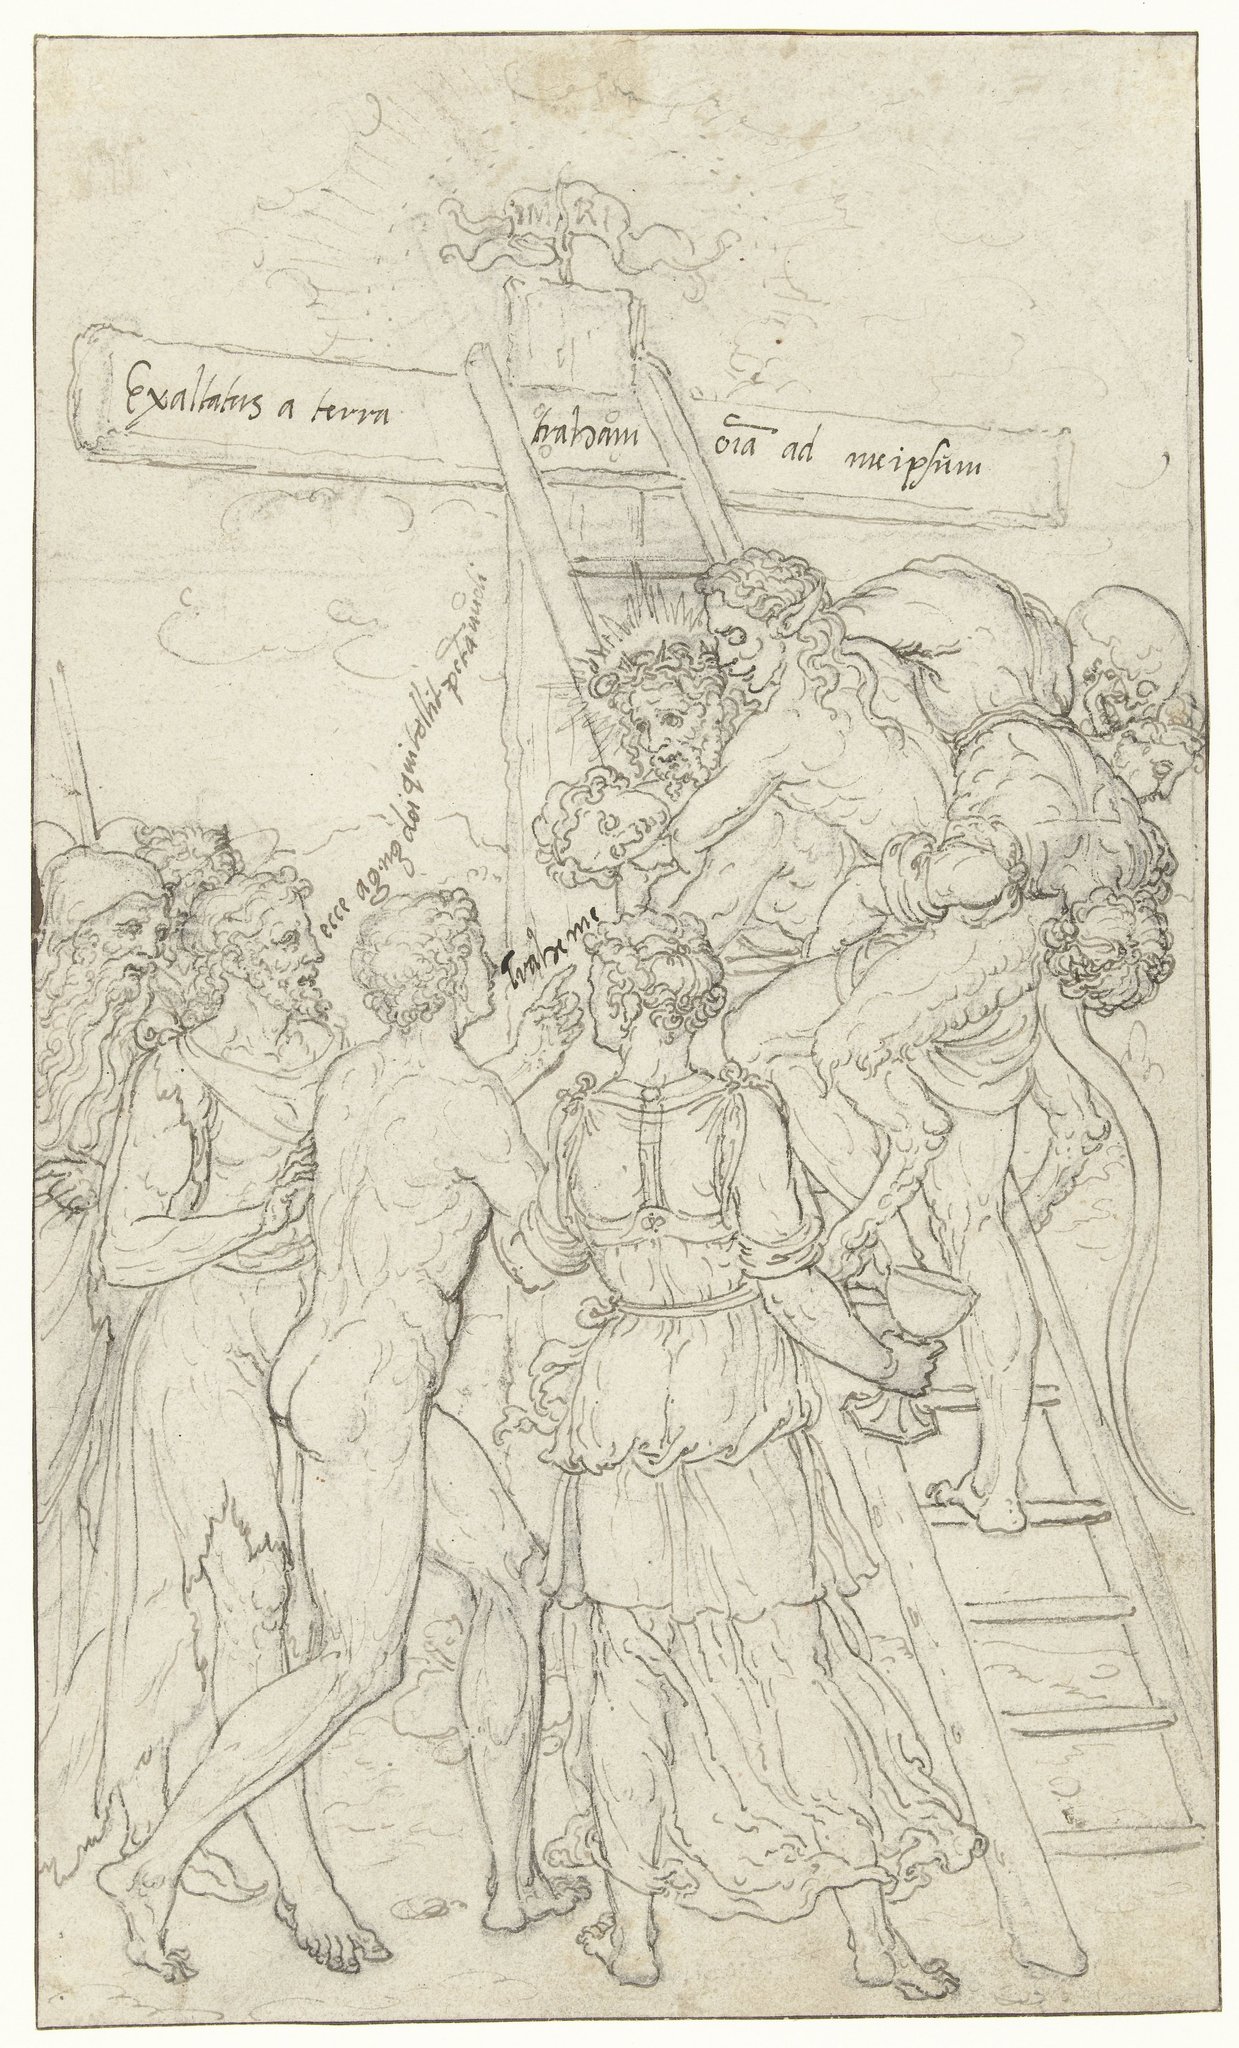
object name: design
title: De weg naar Christus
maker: dirck pietersz. crabeth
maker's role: draughtsman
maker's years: 1520-1574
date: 1550-1574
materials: chalk, ink, paper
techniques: pen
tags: adult christ ~ abstract conceptions, 'imitatio christi', vice, evil, sin; 'peccato' (ripa), doctrine on original sin, and redemption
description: Tussen Johannes de Doper en Trouw (een vrouw met een kelk), vraagt een naakte man aan Christus, die het kruis afdaald met op zijn rug de duivel, verschillende mensen en een lijk, om hem het rechte pad te wijzen. Ontwerp voor een glasruit.